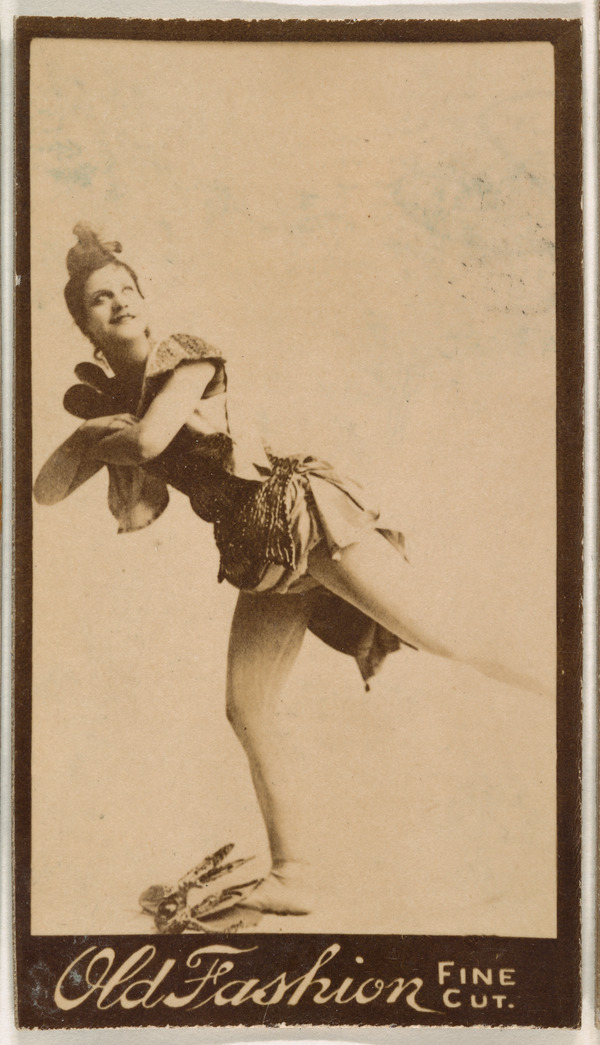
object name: photograph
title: Actress holding leg aloft, from the Actresses series (N664) promoting Old Fashion Fine Cut Tobacco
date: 1888-1890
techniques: albumen silver print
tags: portraits,women,actresses